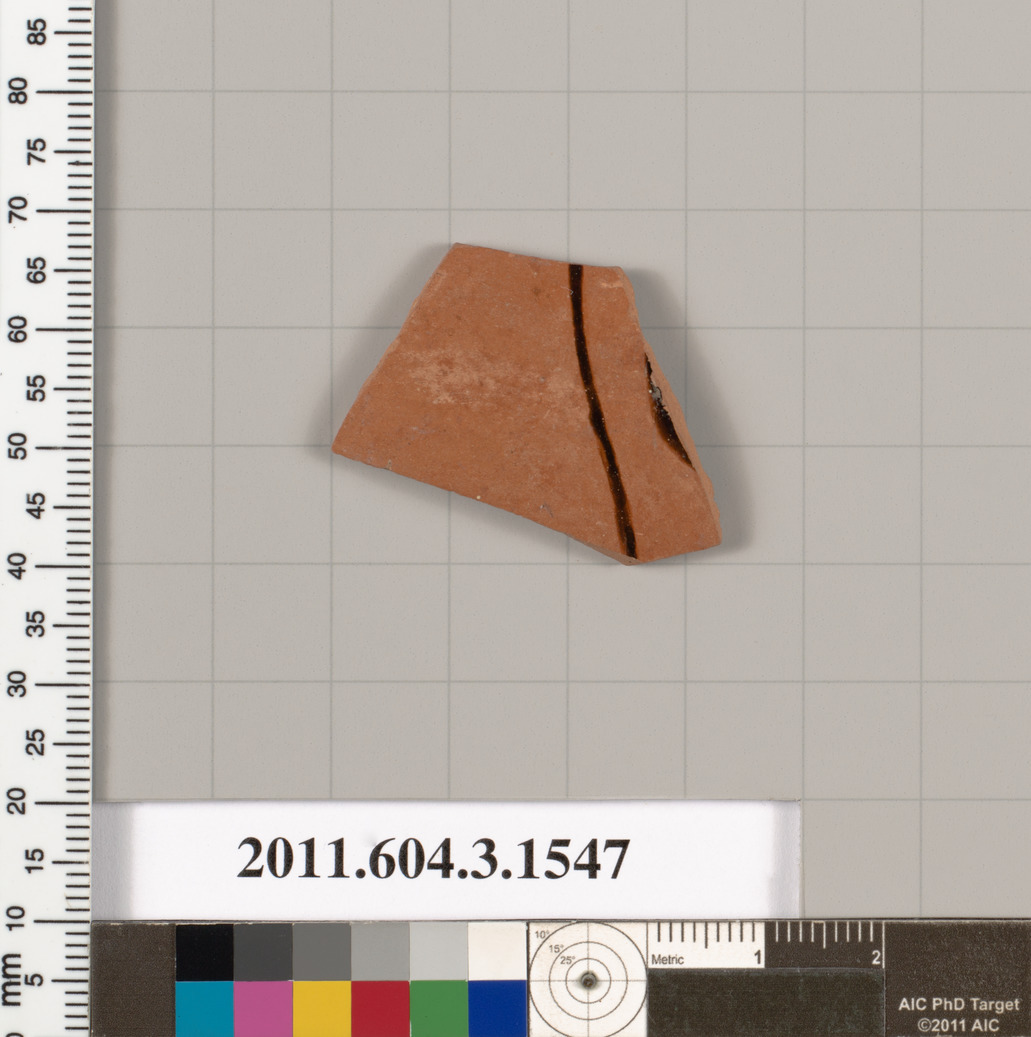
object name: kylix fragment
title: Terracotta fragment of a kylix (drinking cup)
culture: greek, attic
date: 550-526 BCE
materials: terracotta